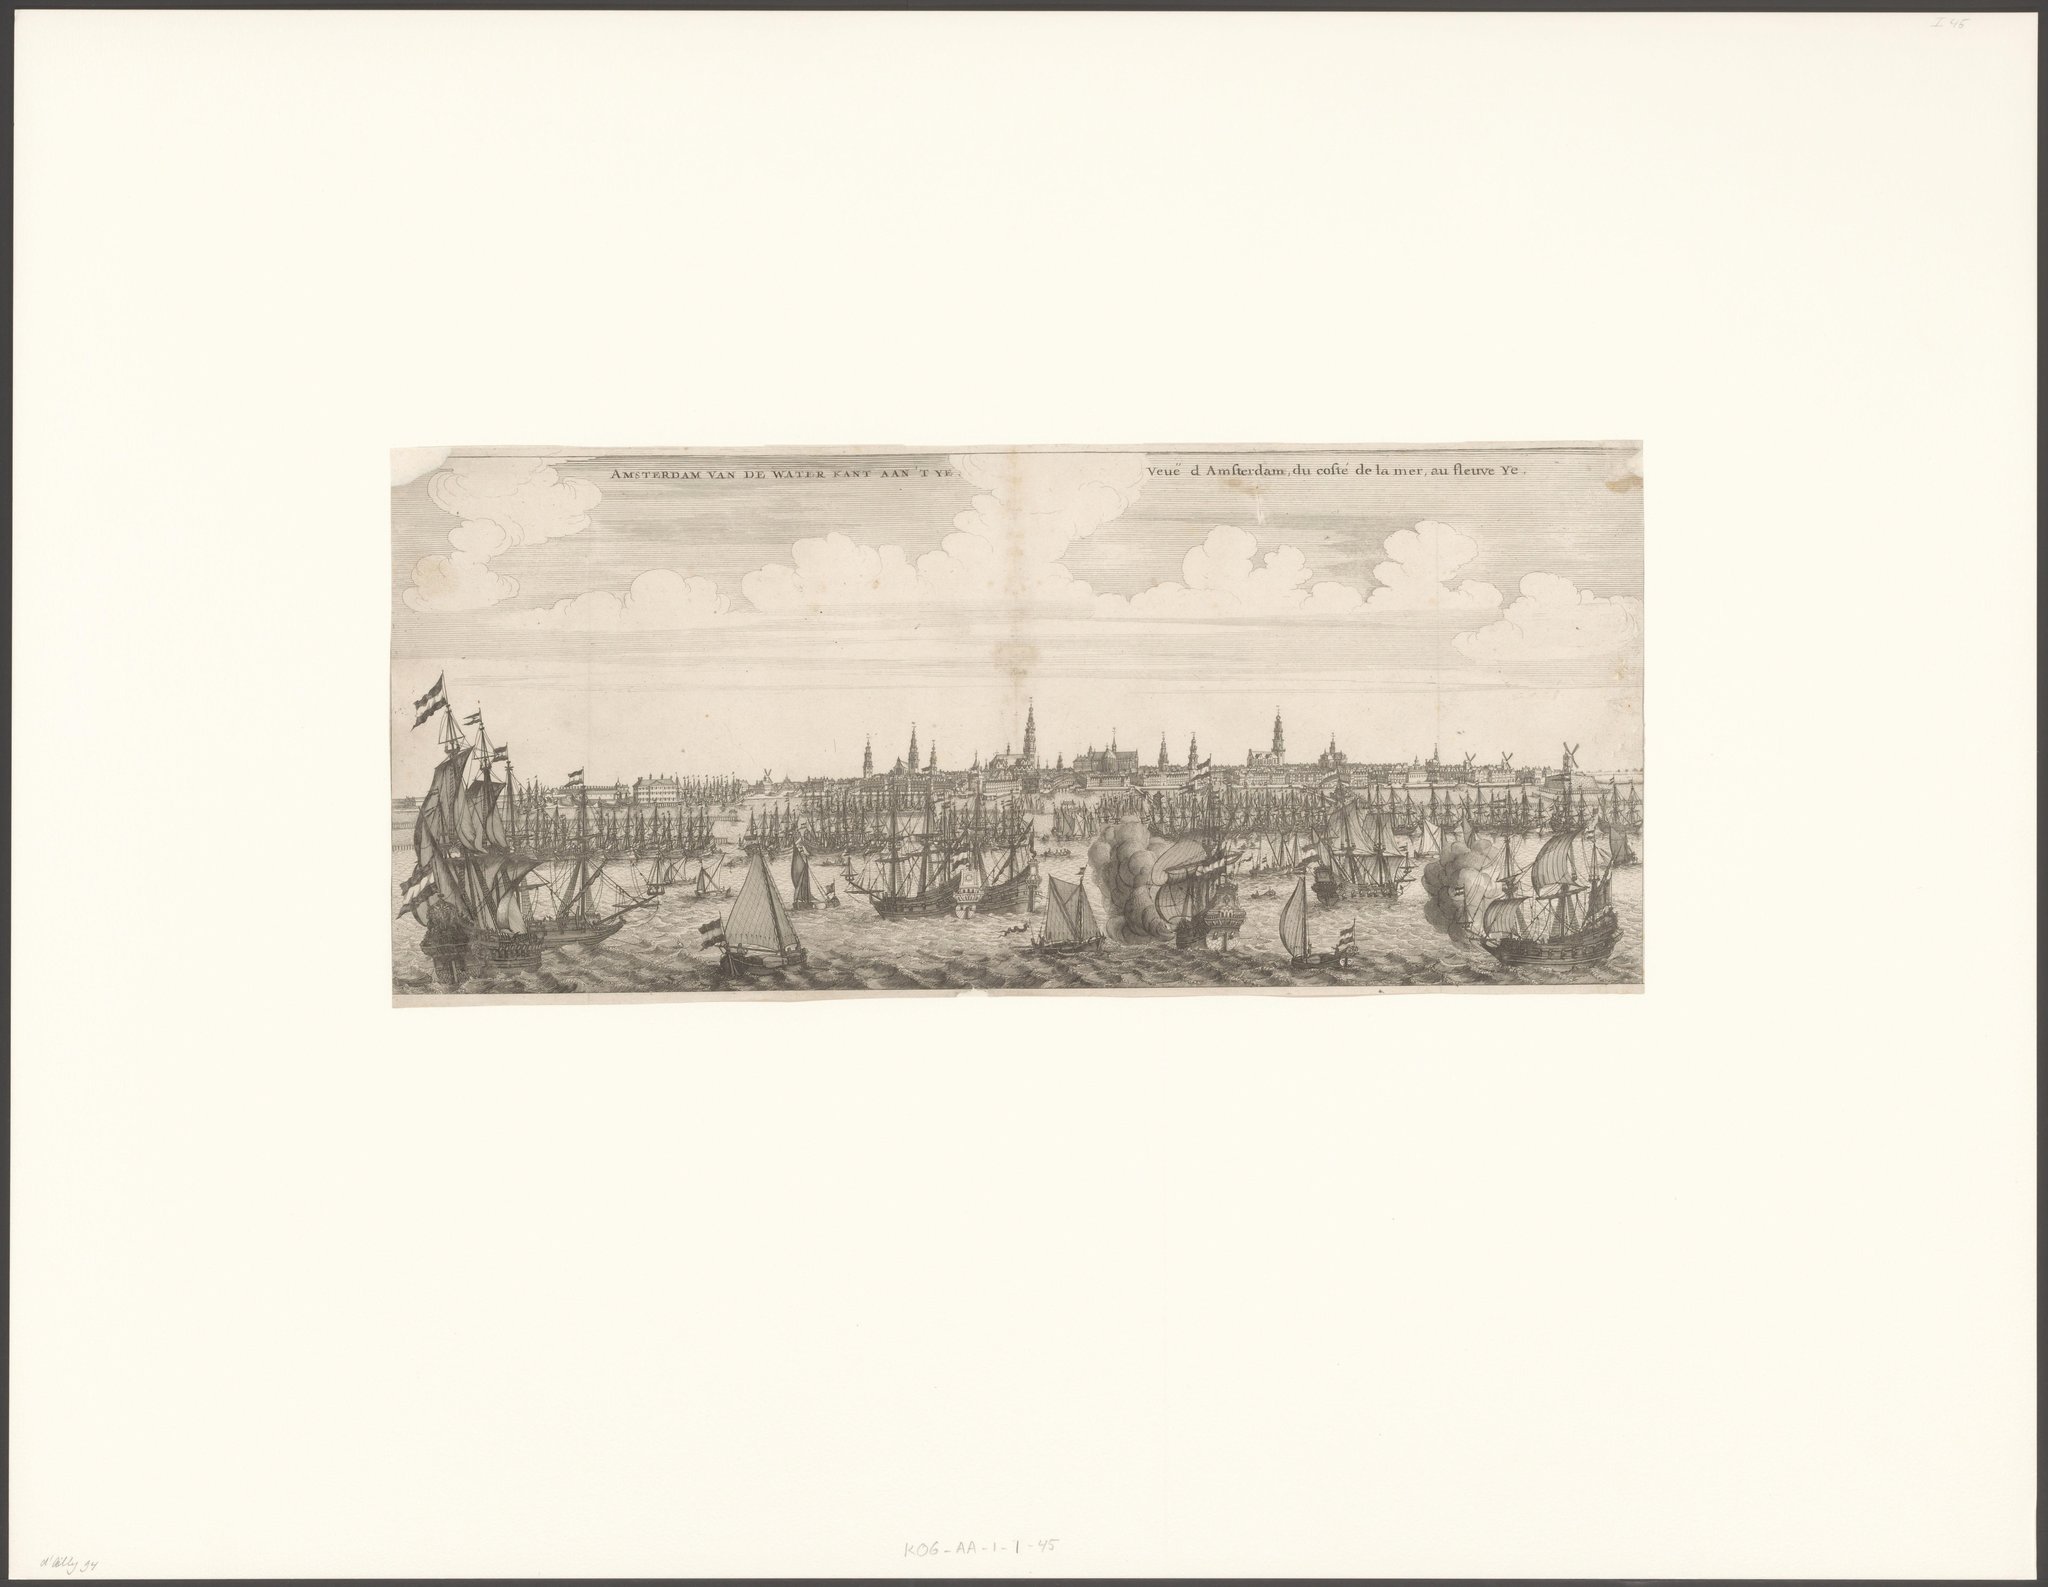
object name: print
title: Amsterdam van de water kant aan 't Ye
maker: Anonymous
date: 1600-1699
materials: paper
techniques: etching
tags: city-view in general; 'veduta', river, ships (in general) - cc - more than one ship, amsterdam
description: Onderwerpsrubriek binnen de Atlas Amsterdam: Gezichten van den geheelen IJkant der Stad.